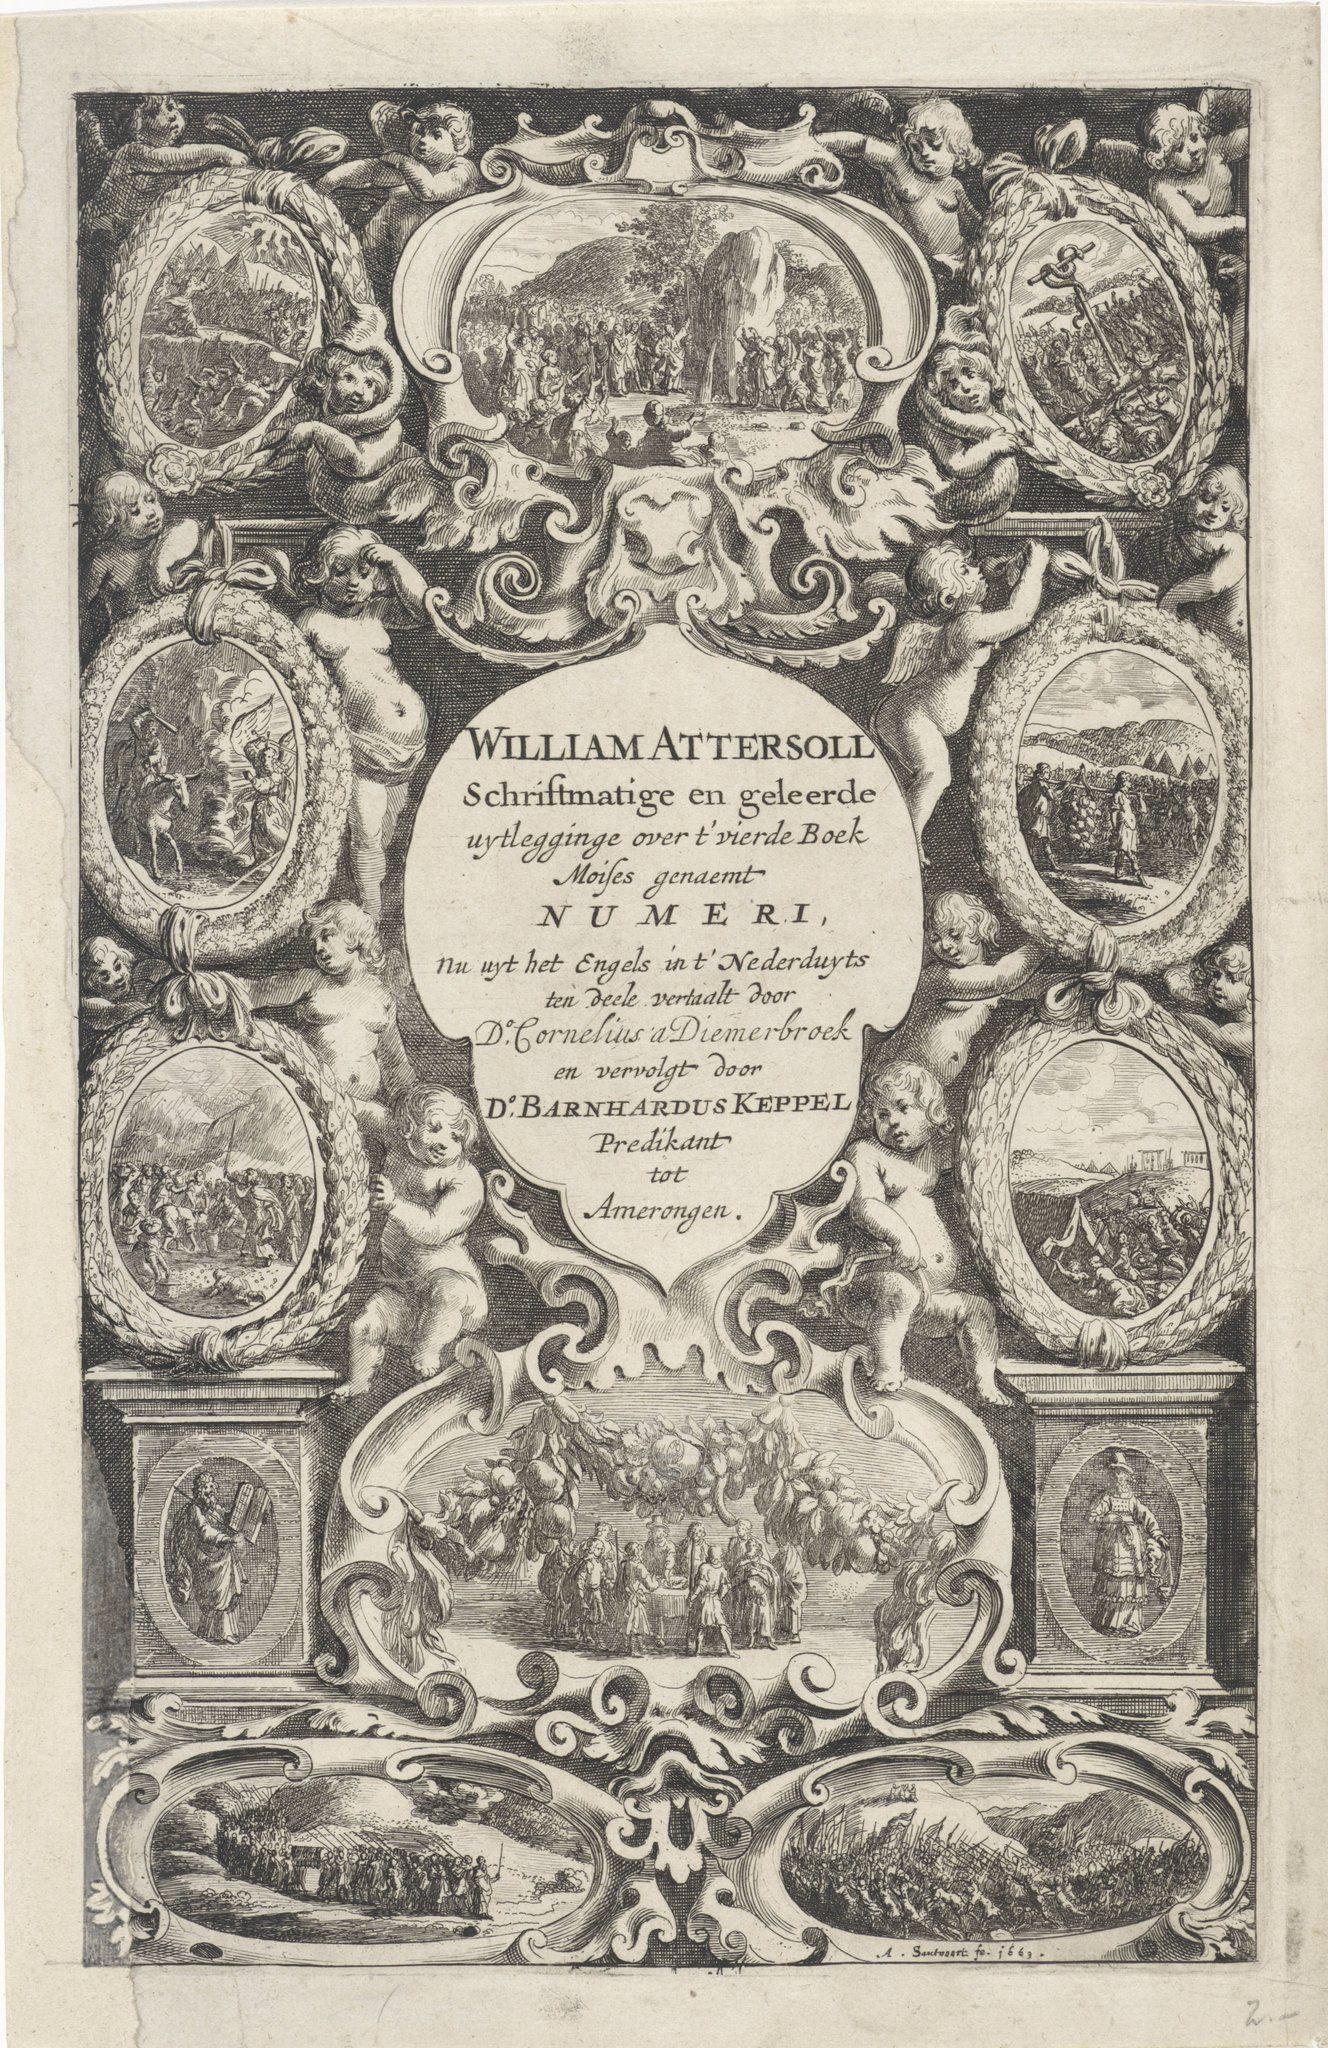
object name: print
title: Titelpagina voor: Attersoll, William. Schriftmatige en geleerde uytlegginge over t'vierde boek Moises genaemt Numeri, 1667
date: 1663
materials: paper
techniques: etching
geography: amsterdam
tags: the ground opens and swallows the rebels dathan and abiram along with their families and possessions, aaron's burial, 'pesah', passover ~ jewish religion, moses sitting on a rock, arms held up by aaron and hur; the amalekites are defeated, the spies take away some of the fruits of canaan and return, usually carrying a large bunch of grapes on a pole, the gathering of manna (in baskets and pots), moses strikes the rock twice in front of the assembled people and water gushes out; the people quench their thirst, title-page, an angel holding a sword bars the way and causes balaam's ass to turn aside; the angel is invisible to balaam, anyone who is bitten by a snake is cured by looking at the brazen serpent; the serpent (or dragon) is usually depicted on a tau-shaped cross or on a pillar, zimri takes a midianite woman, cozbi, into his tent, while the people are lamenting at the entrance of the tabernacle on account of an epidemic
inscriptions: collector's mark: Lugt 2228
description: Titelpagina voor: Attersoll, William. Schriftmatige en geleerde uytlegginge over t'vierde boek Moises genaemt Numeri, Amsterdam: Gerrit van Goedesberg, 1667